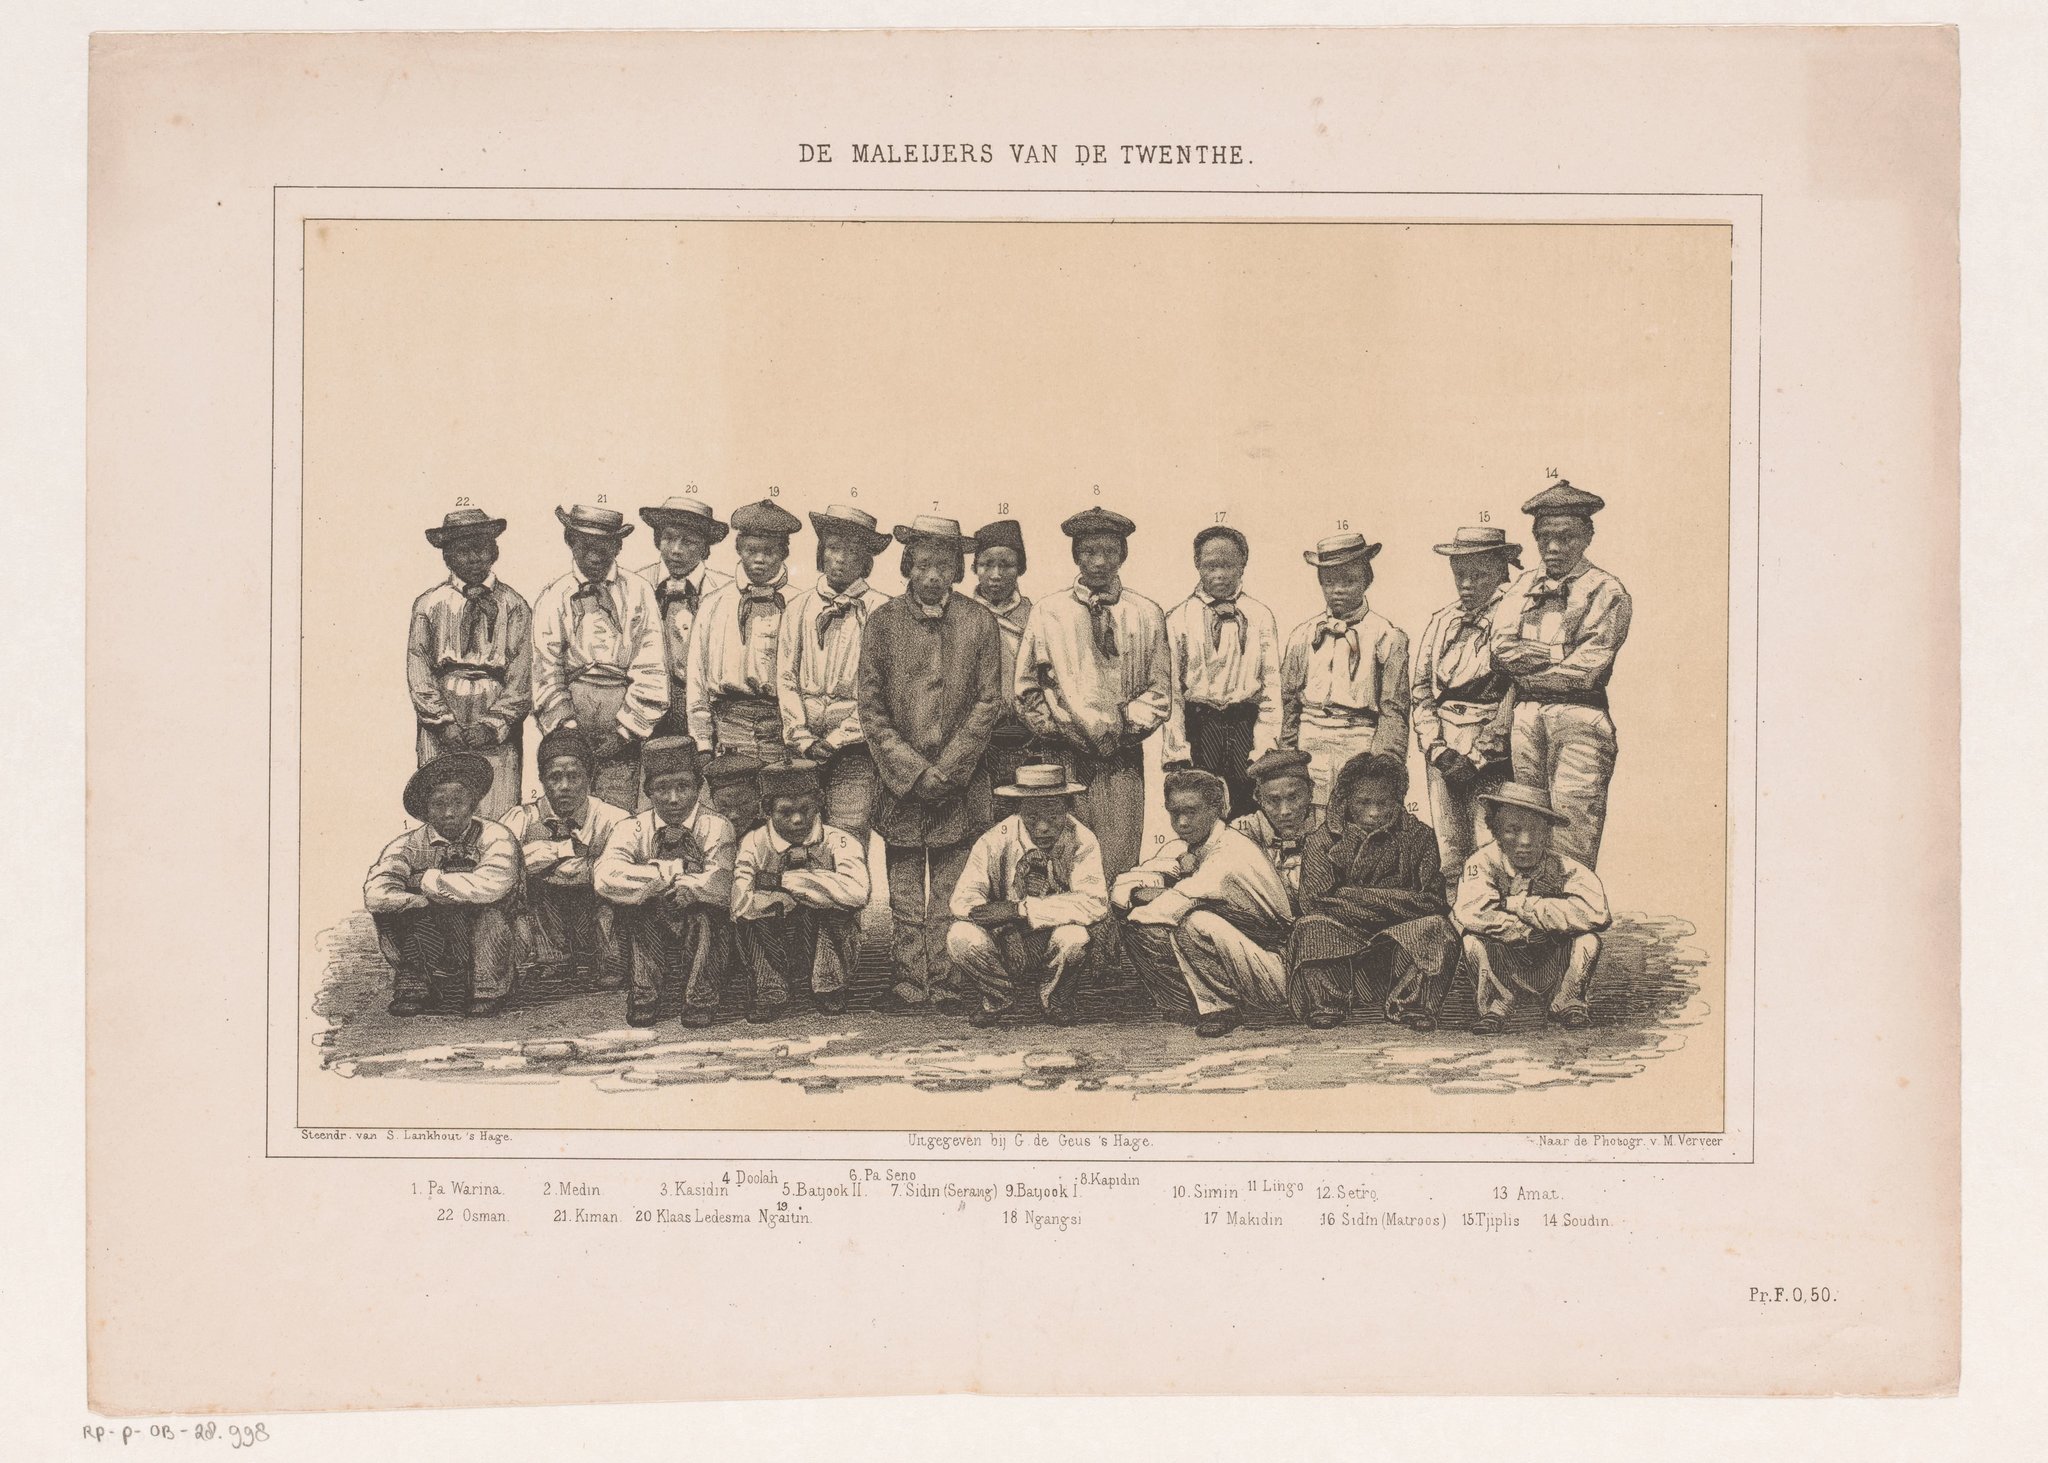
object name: print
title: Maleiers van het koopvaardijschip 'Twenthe'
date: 1858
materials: paper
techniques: tone lithography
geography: the hague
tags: the accused, historical person (with name) - historical person (with name) portrayed in a group, in a group-portrait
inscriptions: collector's mark: Lugt 2228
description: Groepsportret van de tweeëntwintig Maleiers van het koopvaardijschip 'Twenthe', die op 12 augustus 1856 op weg naar Oost-Indië muiterij pleegden en een deel van de bemanning vermoorden. Vier van hen werden op 1 maart 1858 tot tuchthuisstraf veroordeeld. Onderaan de namen 1-22.